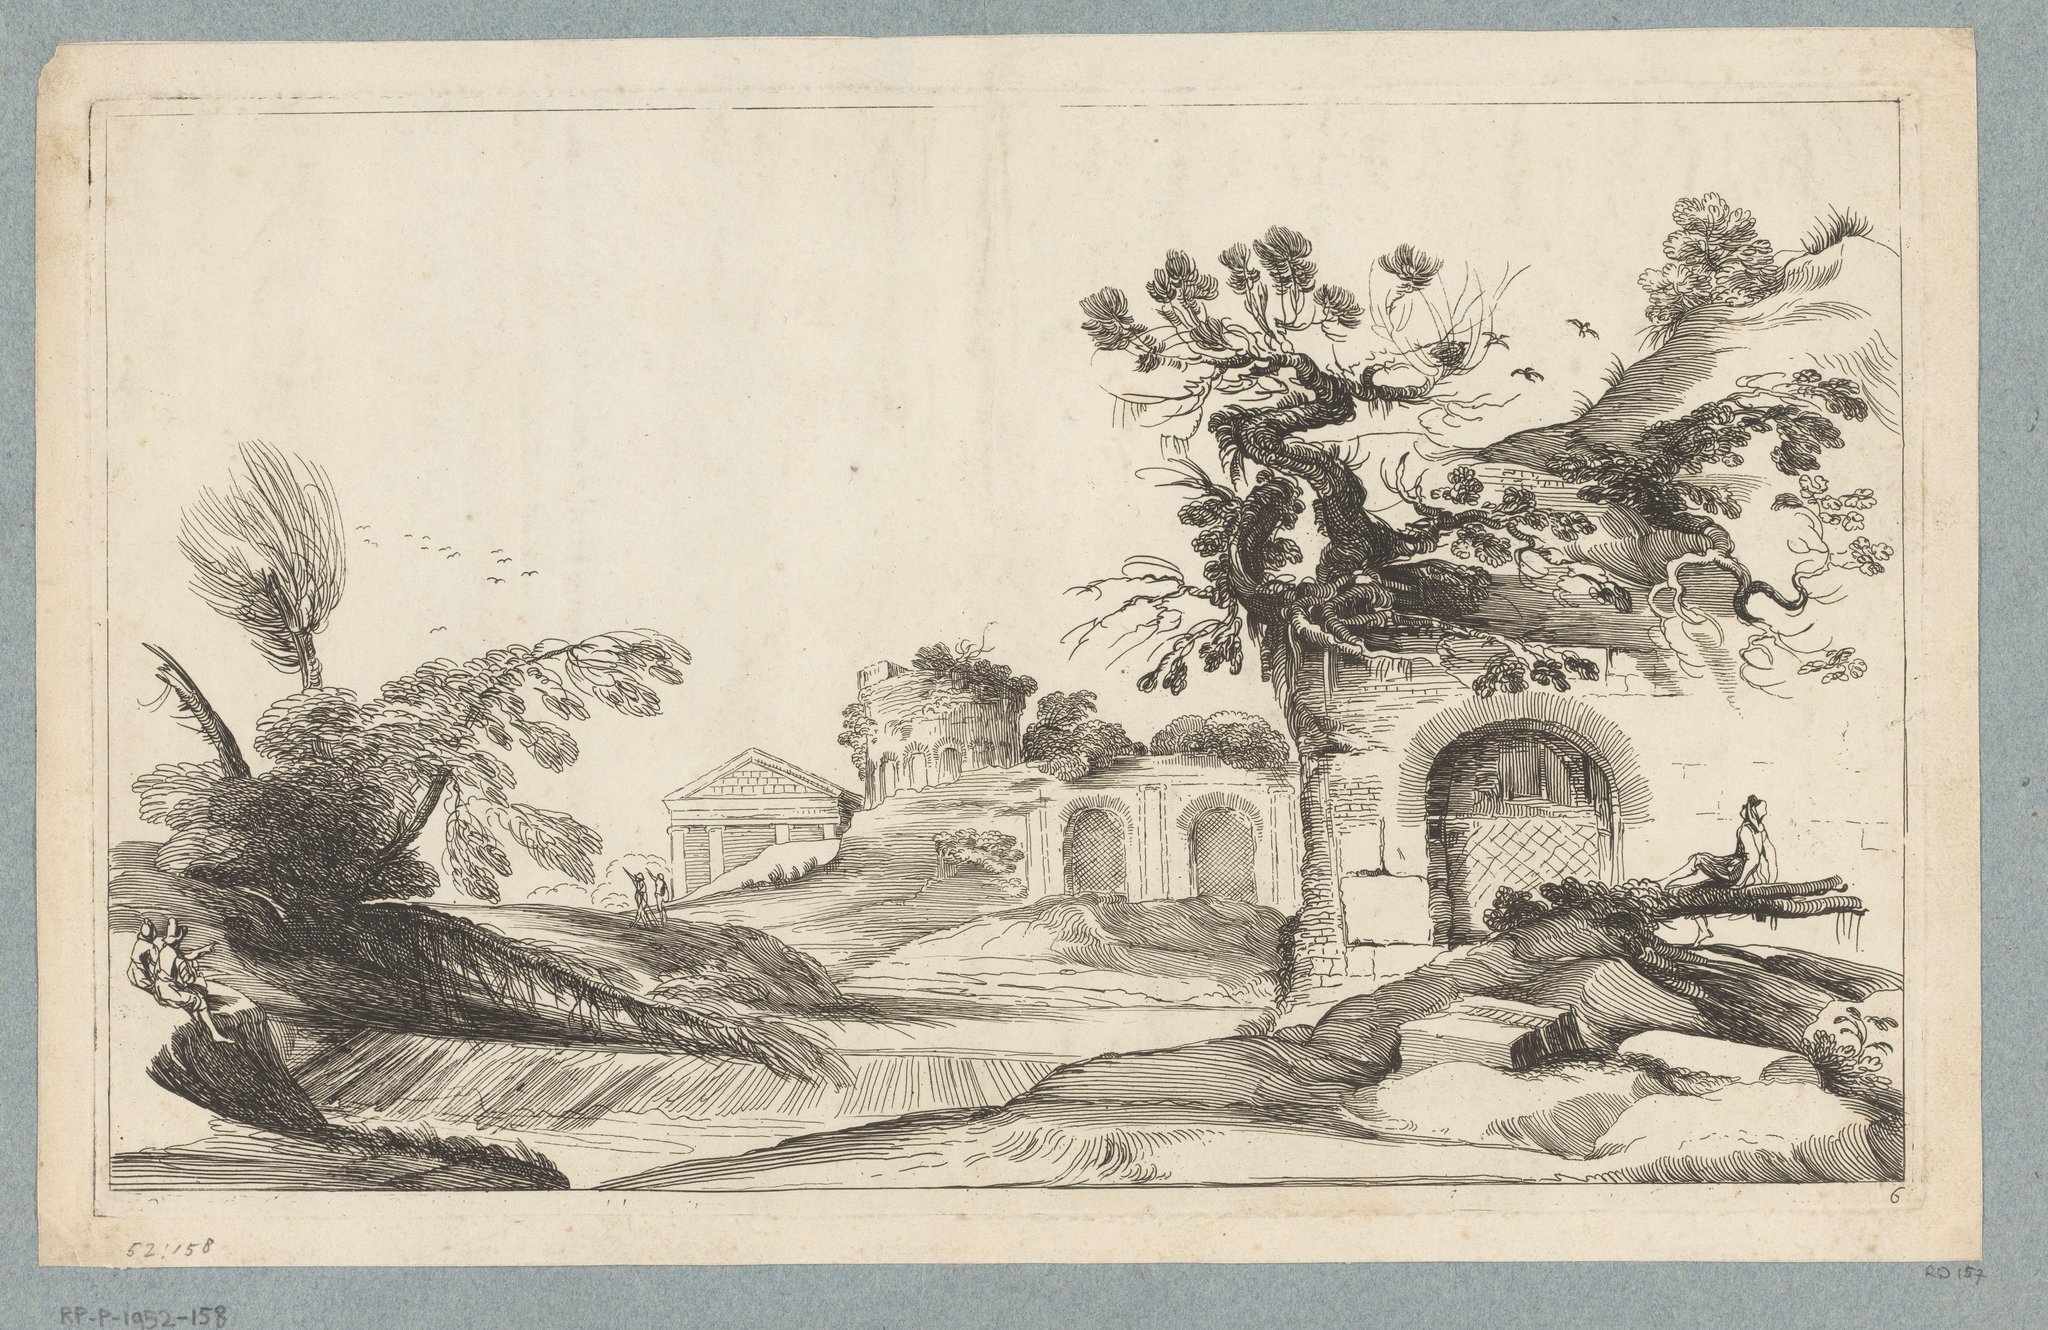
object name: print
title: Landschap met waterval en ruïnes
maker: jean pesne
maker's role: print maker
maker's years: 1623-1700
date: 1666-1695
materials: paper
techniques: etching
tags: waterfall, landscape with ruins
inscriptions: number: ‘6’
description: Prent maakt deel uit van een serie van 283 prenten, ongenummerde staat.